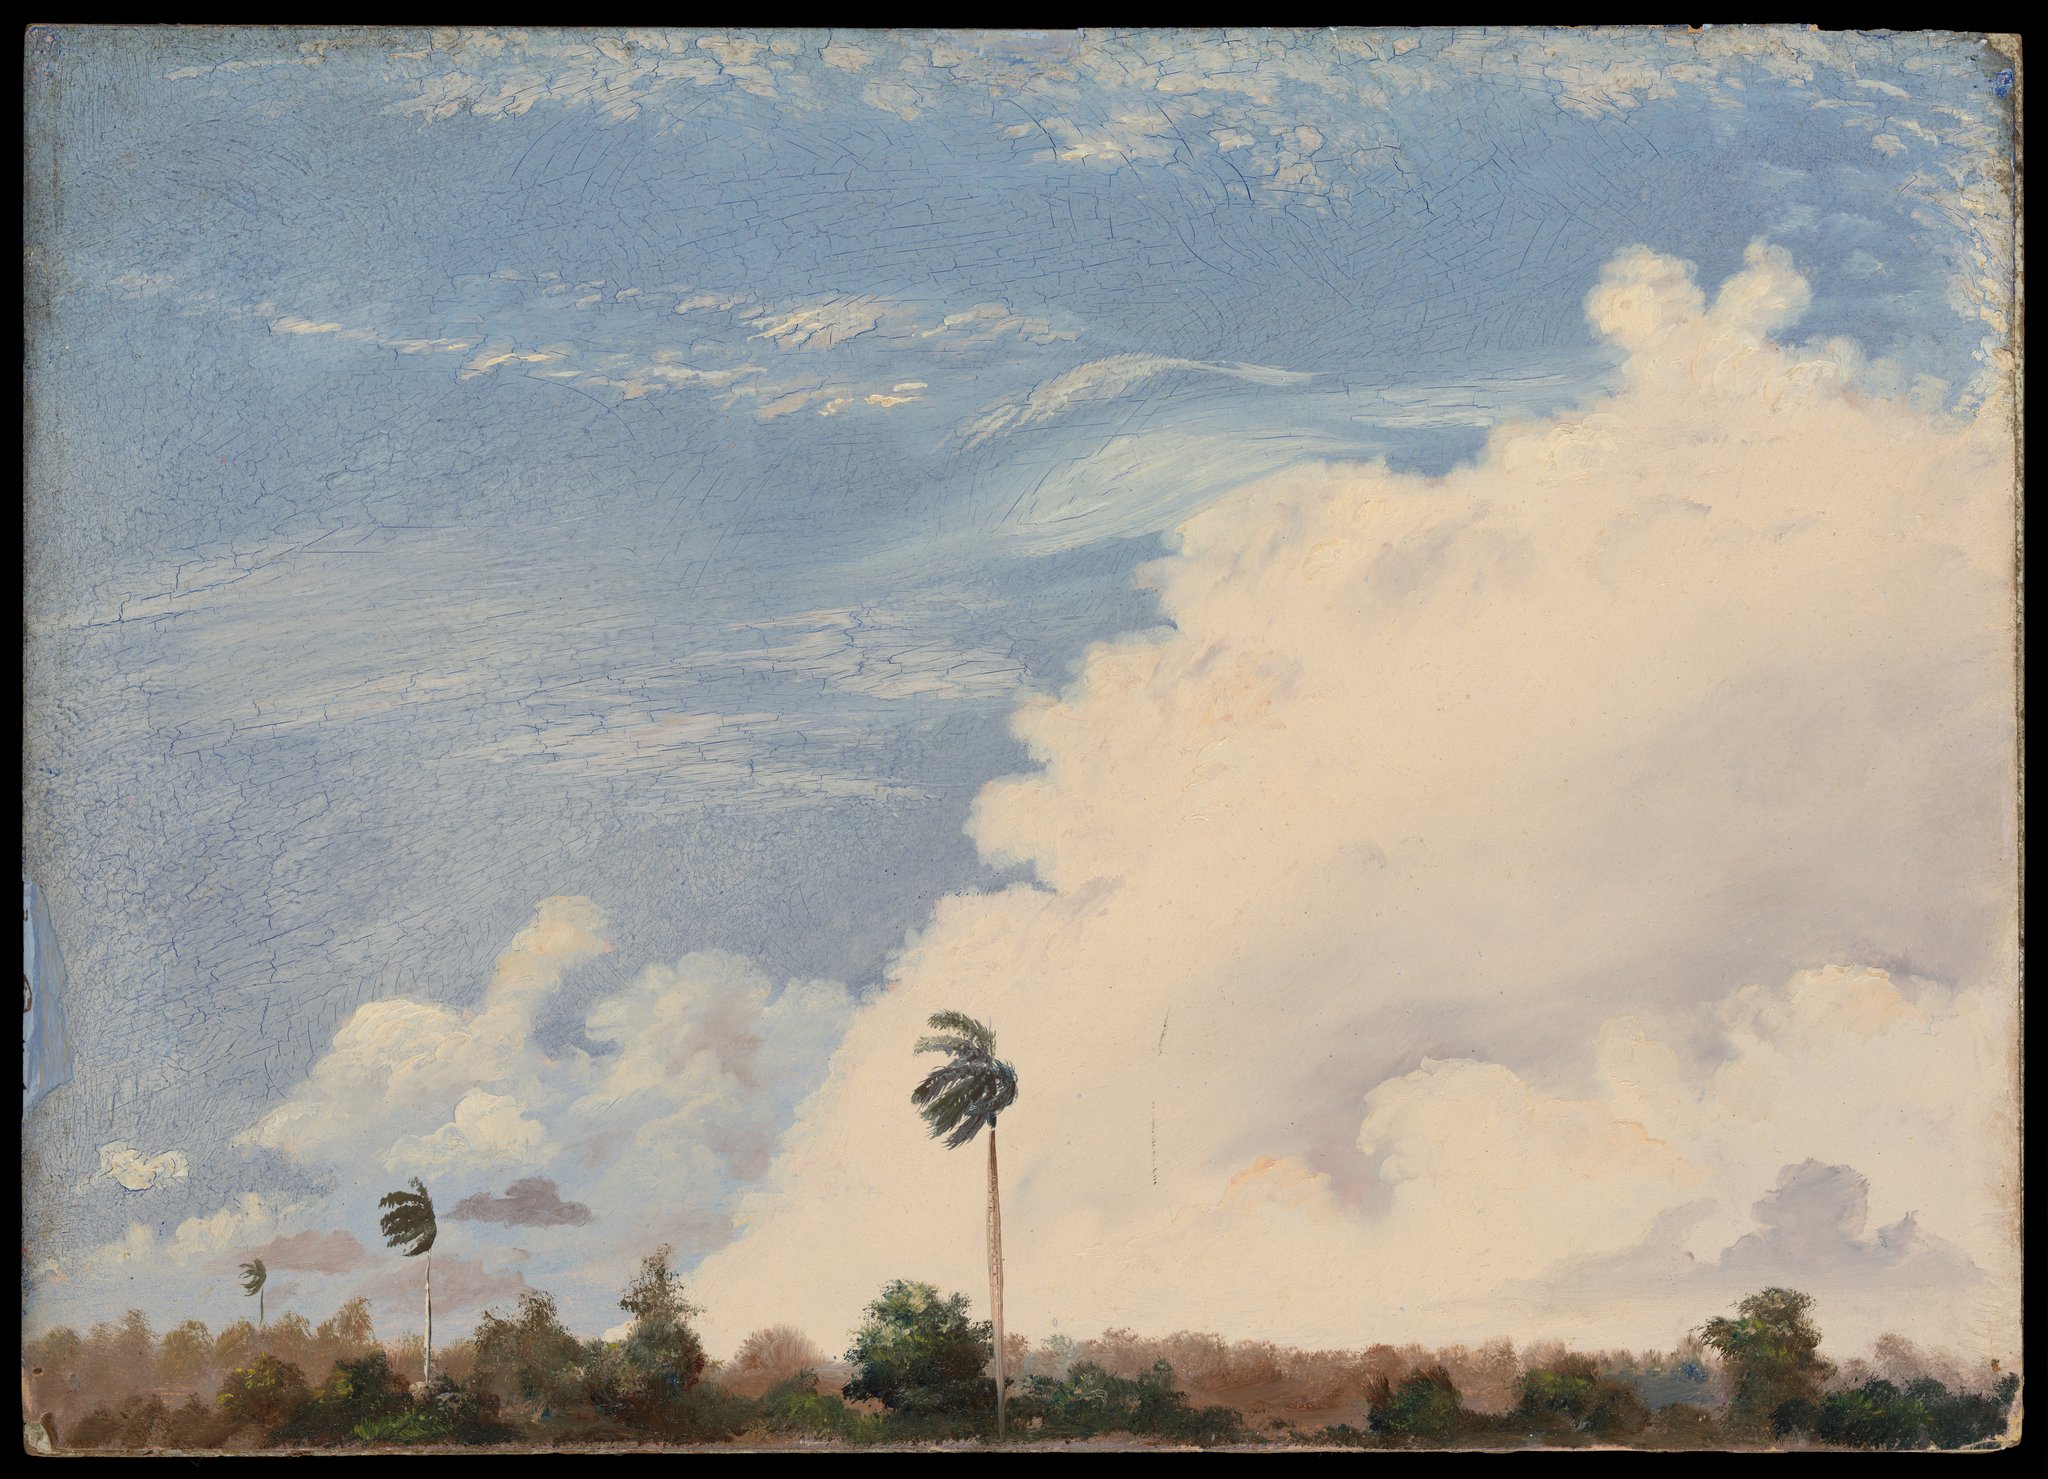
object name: painting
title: Sky – Northern Cuba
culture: american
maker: charles dewolf brownell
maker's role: artist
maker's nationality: american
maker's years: 1822-1909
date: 1853-1866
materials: board, oil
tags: sky,clouds